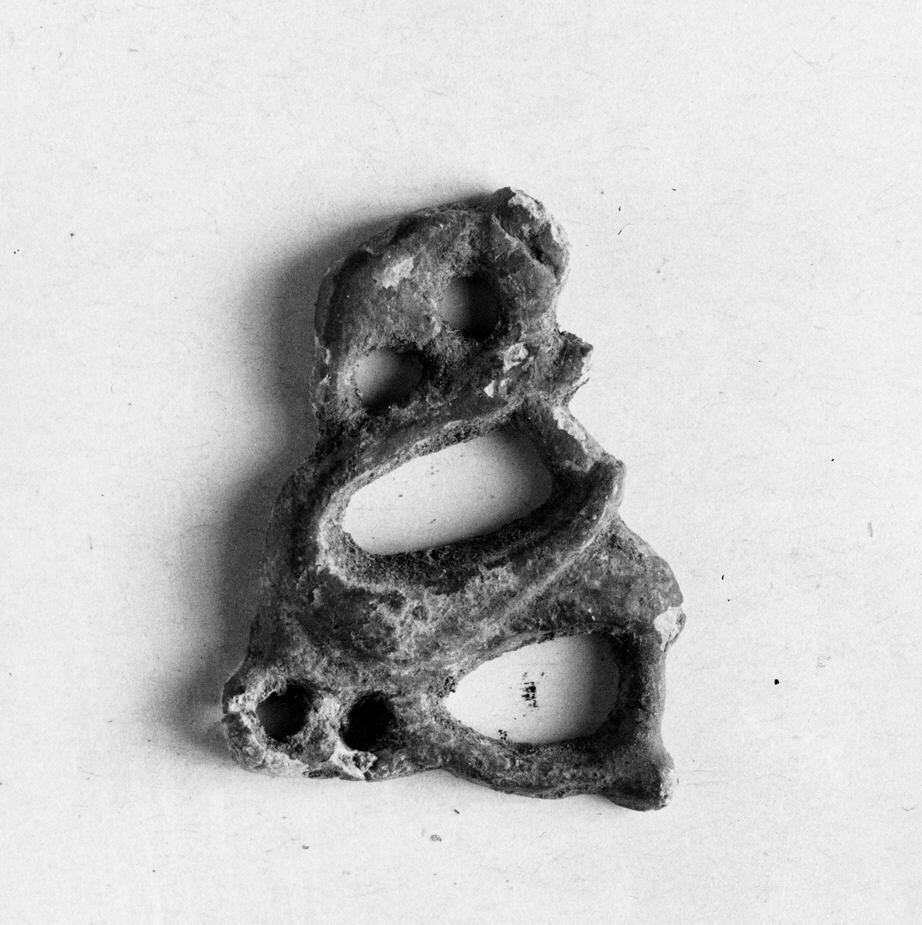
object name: ornament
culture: korean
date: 918-1392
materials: bronze